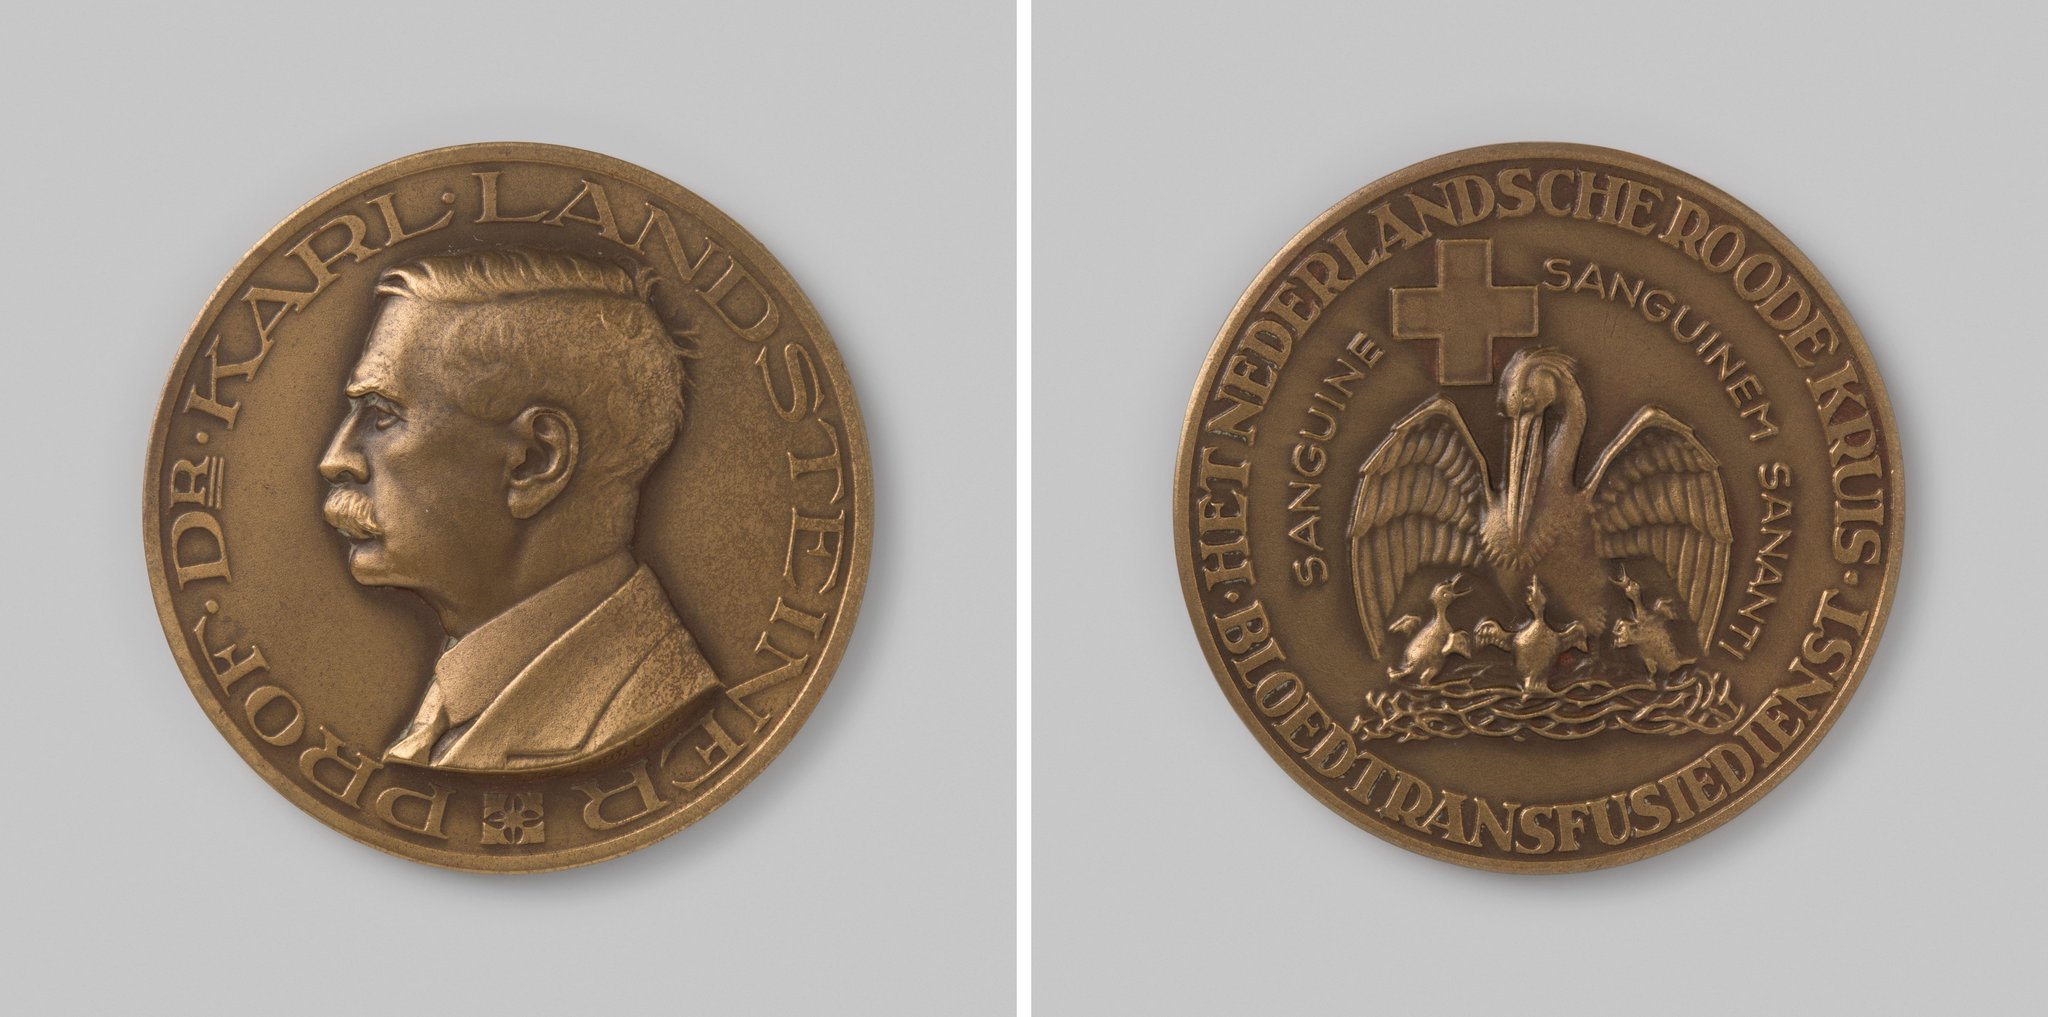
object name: history medal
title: Prof. Dr. Karl Landsteiner / Het Nederlandse Rode Kruis - Bloedtransfusiedienst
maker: Anonymous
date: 1939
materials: bronze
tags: rode kruis, het nederlandse, karl landsteiner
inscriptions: circumscription: ‘HET NEDERLANDSCHE ROODE KRUIS . BLOEDTRANSFUSIEDIENST’, circumscription: ‘PROF. DR. KARL LANDSTEINER’, circumscription: ‘SANGUINE SANGUINEM SANANTI’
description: Bronzen penning. Voorzijde: portret van Prof. Dr. Karl Landsteiner met omschrift. Keerzijde: pelikaan met uitslaande vleugels op nest met 3 jongen. Linksboven een kruis. Omschrift.